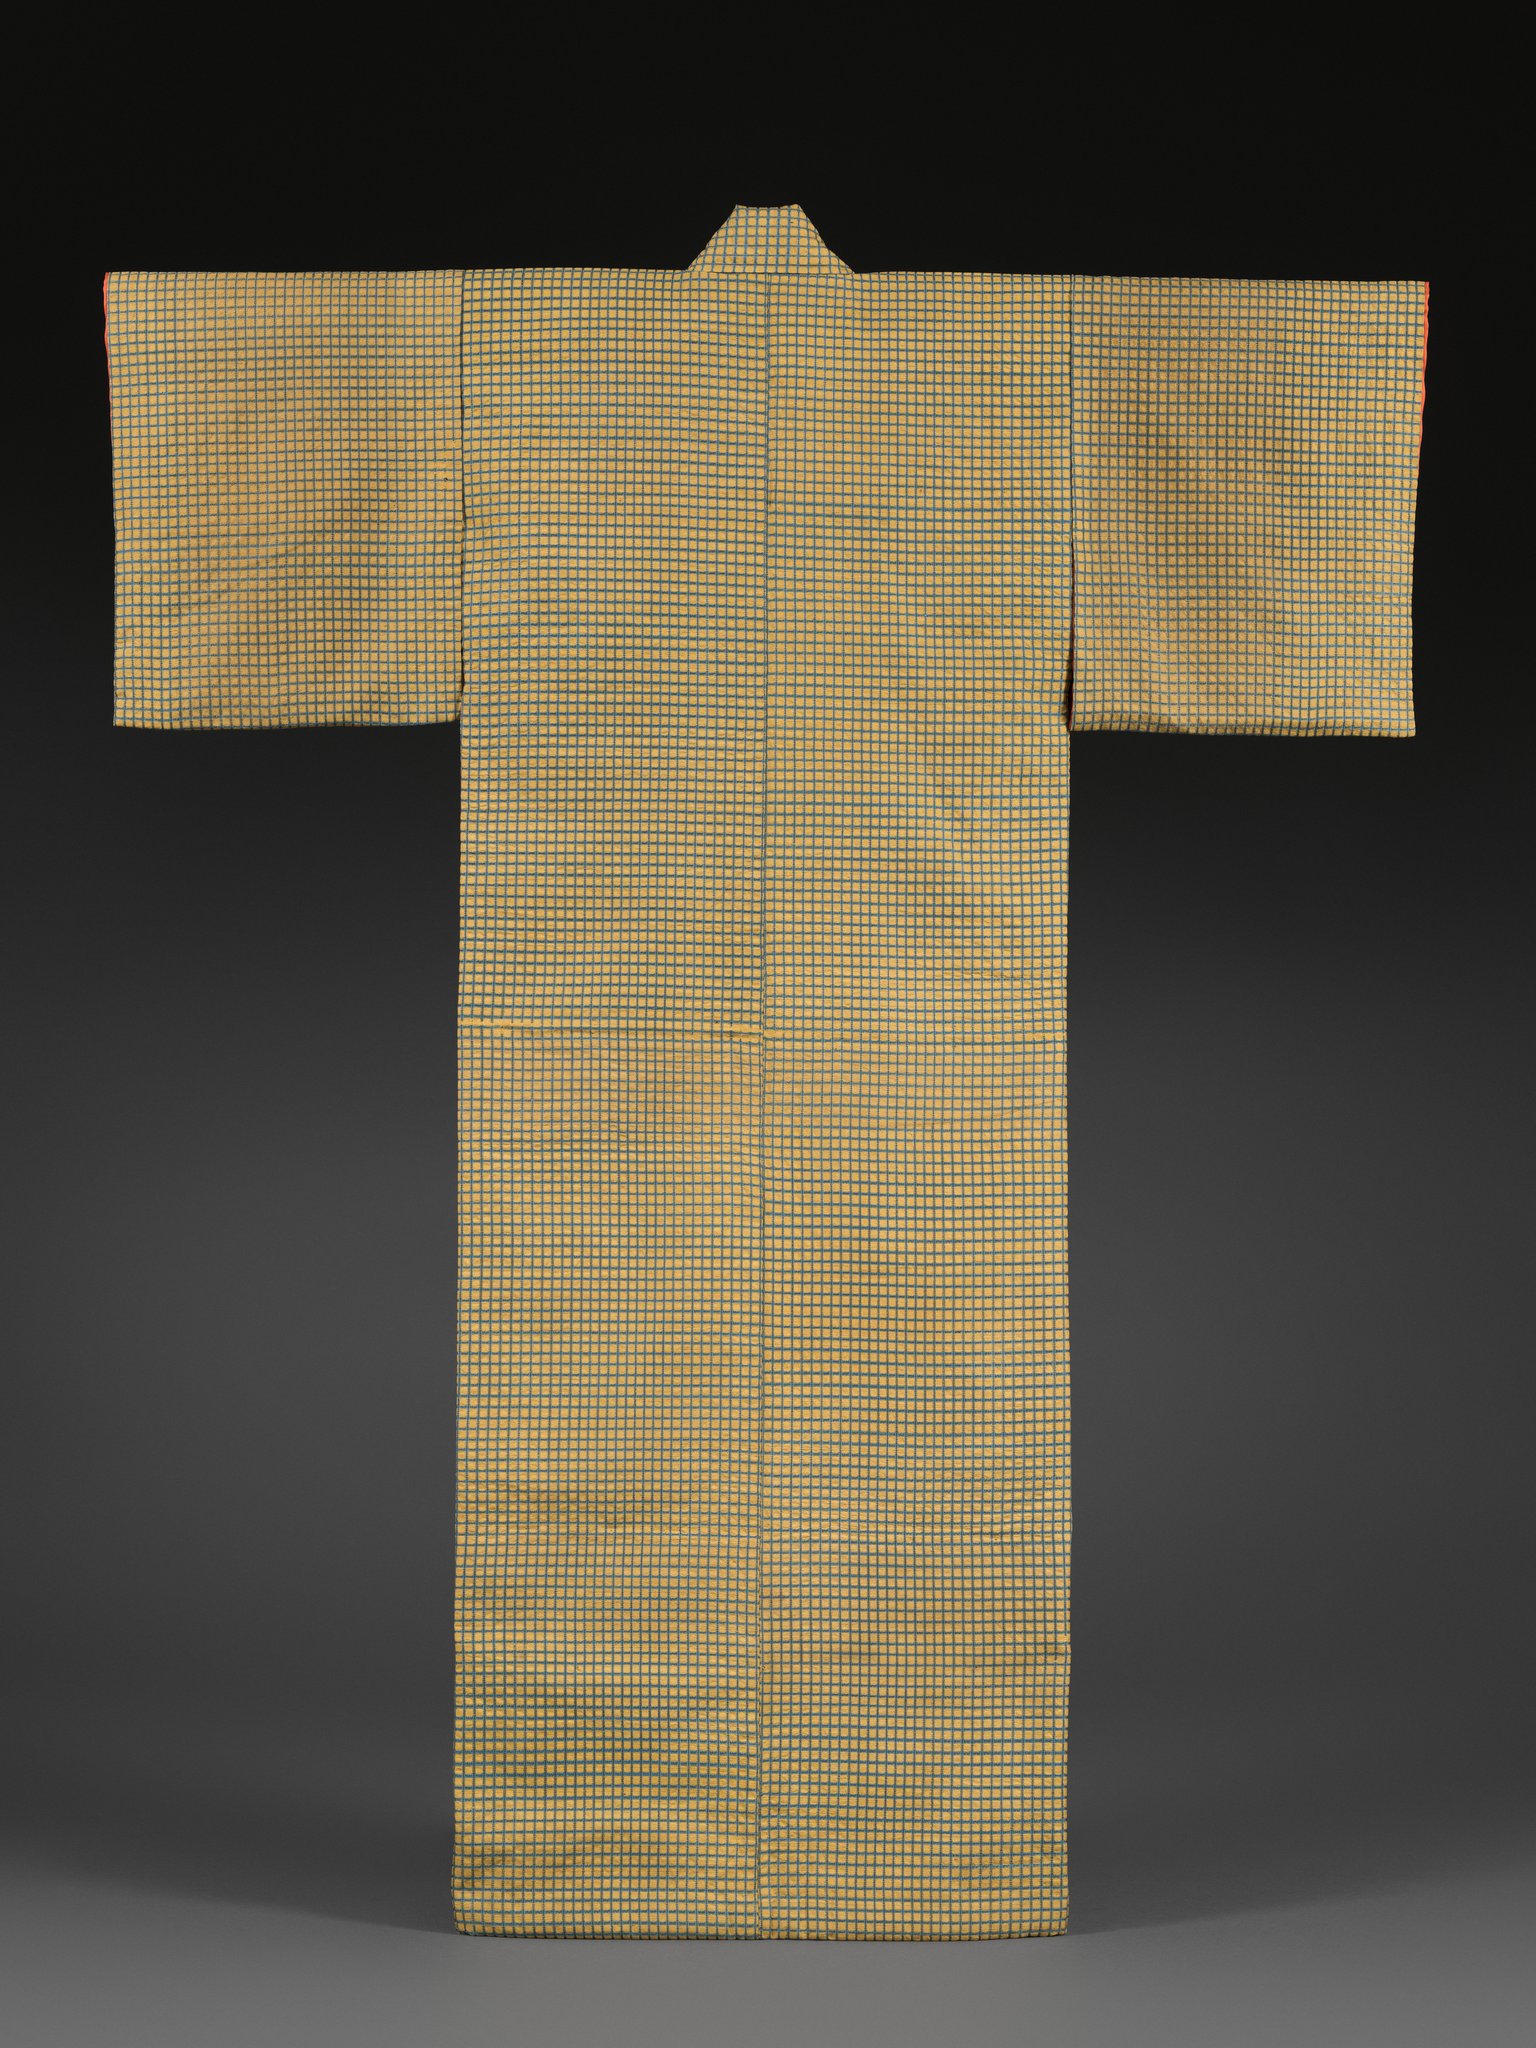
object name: kimono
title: Kimono (Shijira)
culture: japanese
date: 1834-1866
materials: silk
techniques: weave